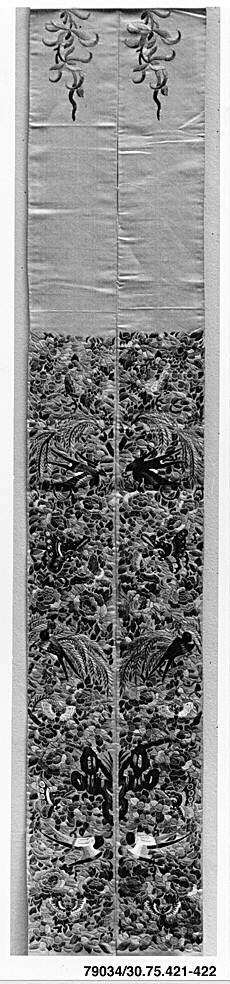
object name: sleeve band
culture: chinese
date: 1801-1900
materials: silk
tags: leaves